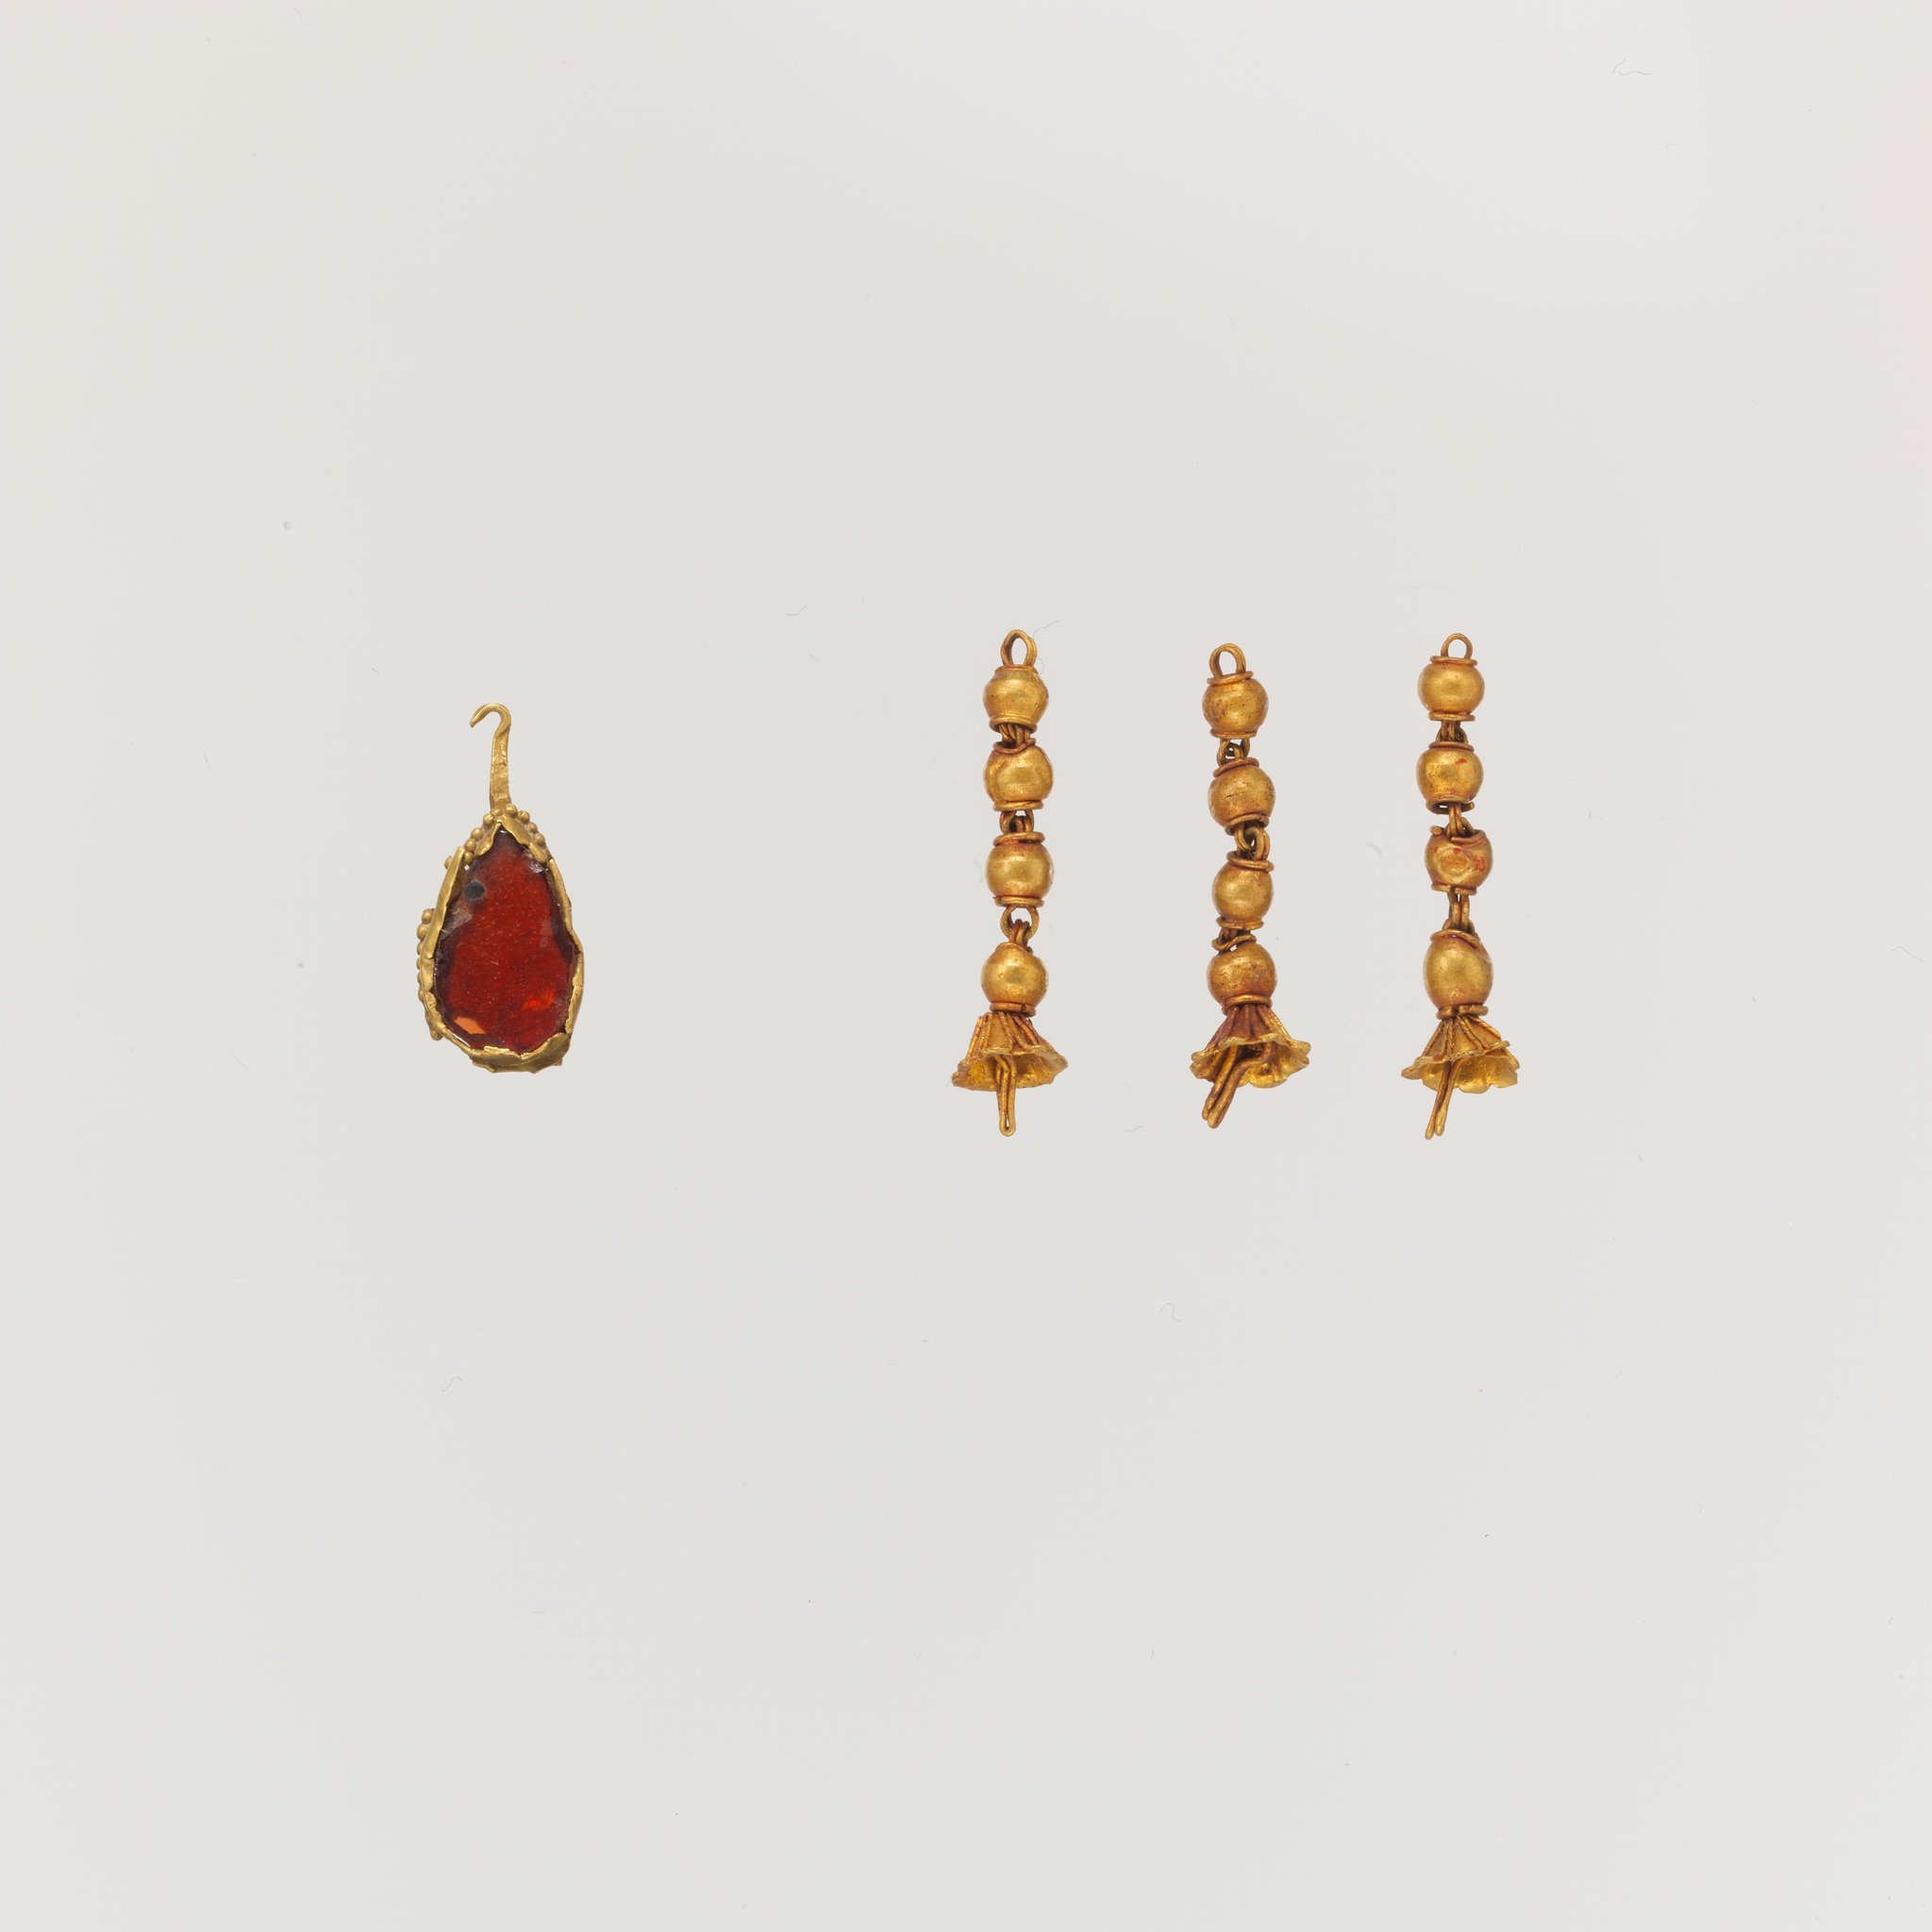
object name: pendant with garnet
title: Gold pendant with garnet and three gold tassels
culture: greek, south italian, tarentine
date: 300-201 BCE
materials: gemstone, gold